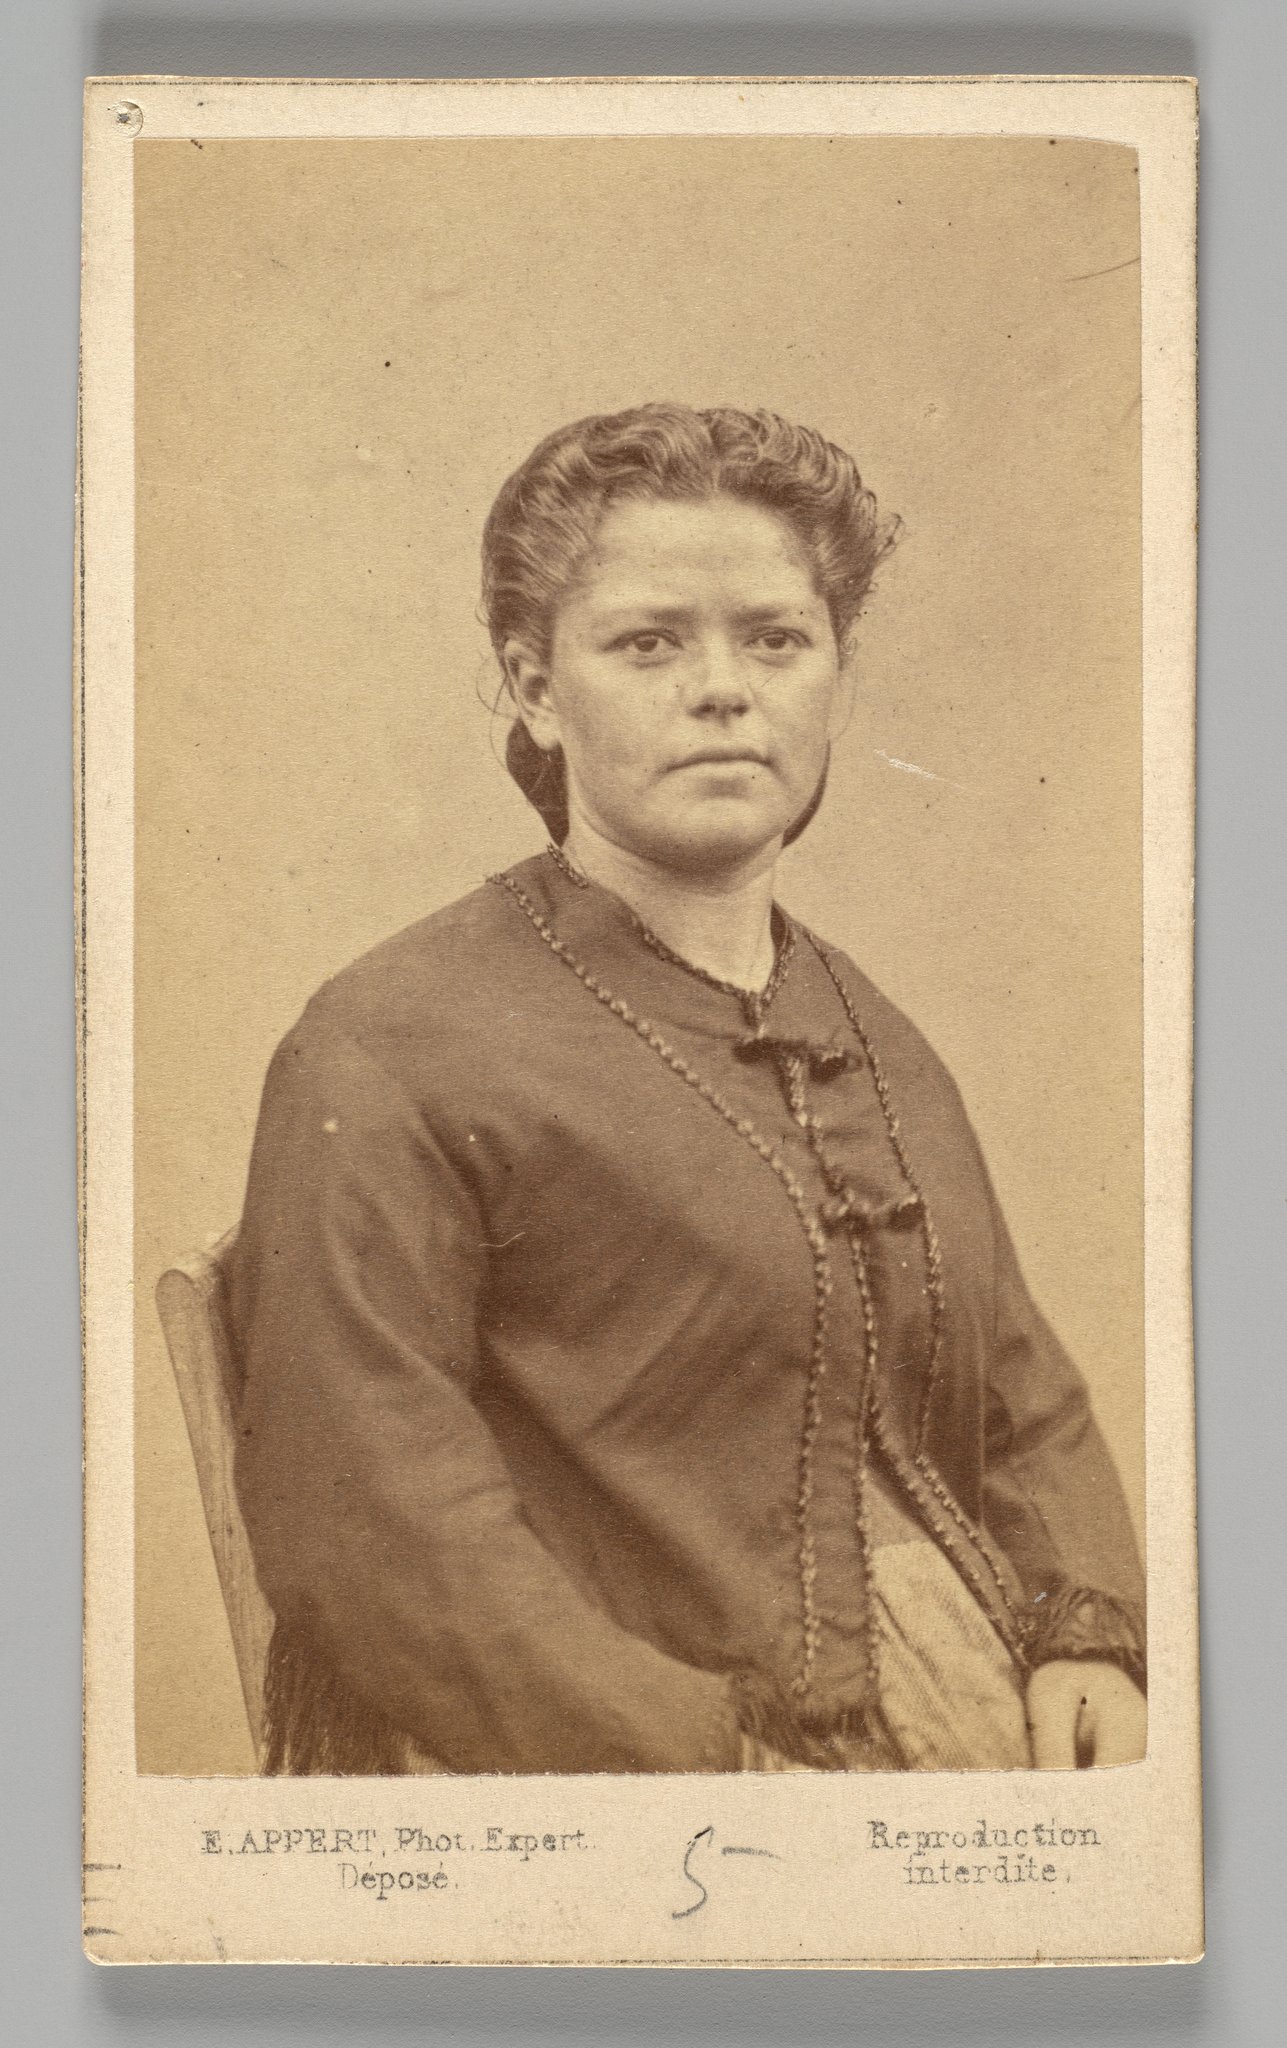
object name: carte de visite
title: [Member of the Paris Commune: Augustine Prévost [Prévot], cantinière, à perpétuité, des fédérés]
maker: ernest eugène appert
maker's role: artist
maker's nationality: french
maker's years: 1831-1891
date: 1871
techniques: albumen silver print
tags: portraits,women